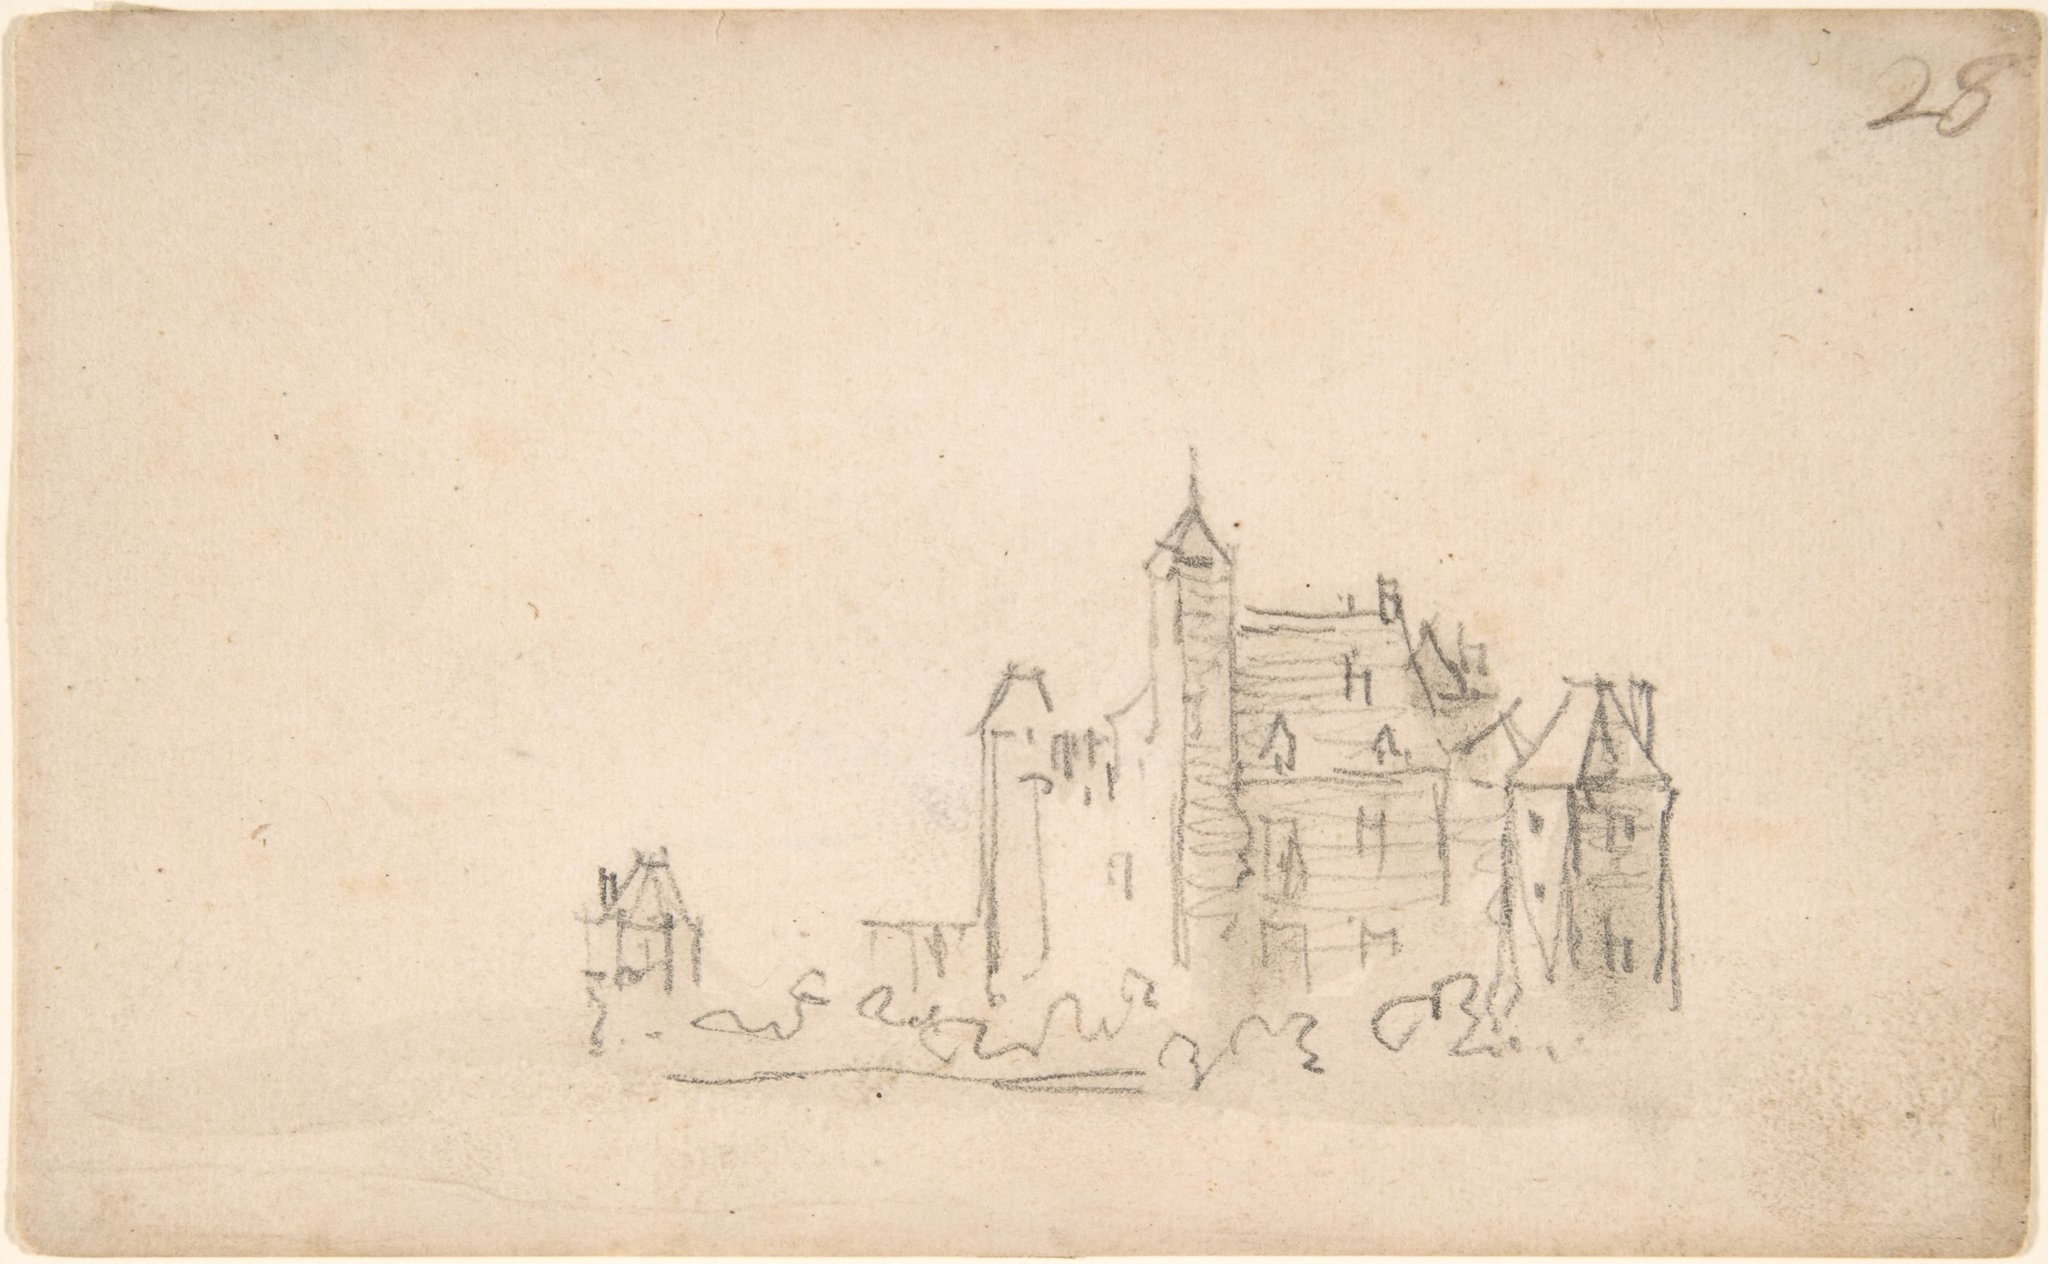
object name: drawing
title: A Castle (on the Rhine?)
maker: jan van goyen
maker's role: artist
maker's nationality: dutch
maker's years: 1596-1656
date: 1601-1666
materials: chalk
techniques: wash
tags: castles